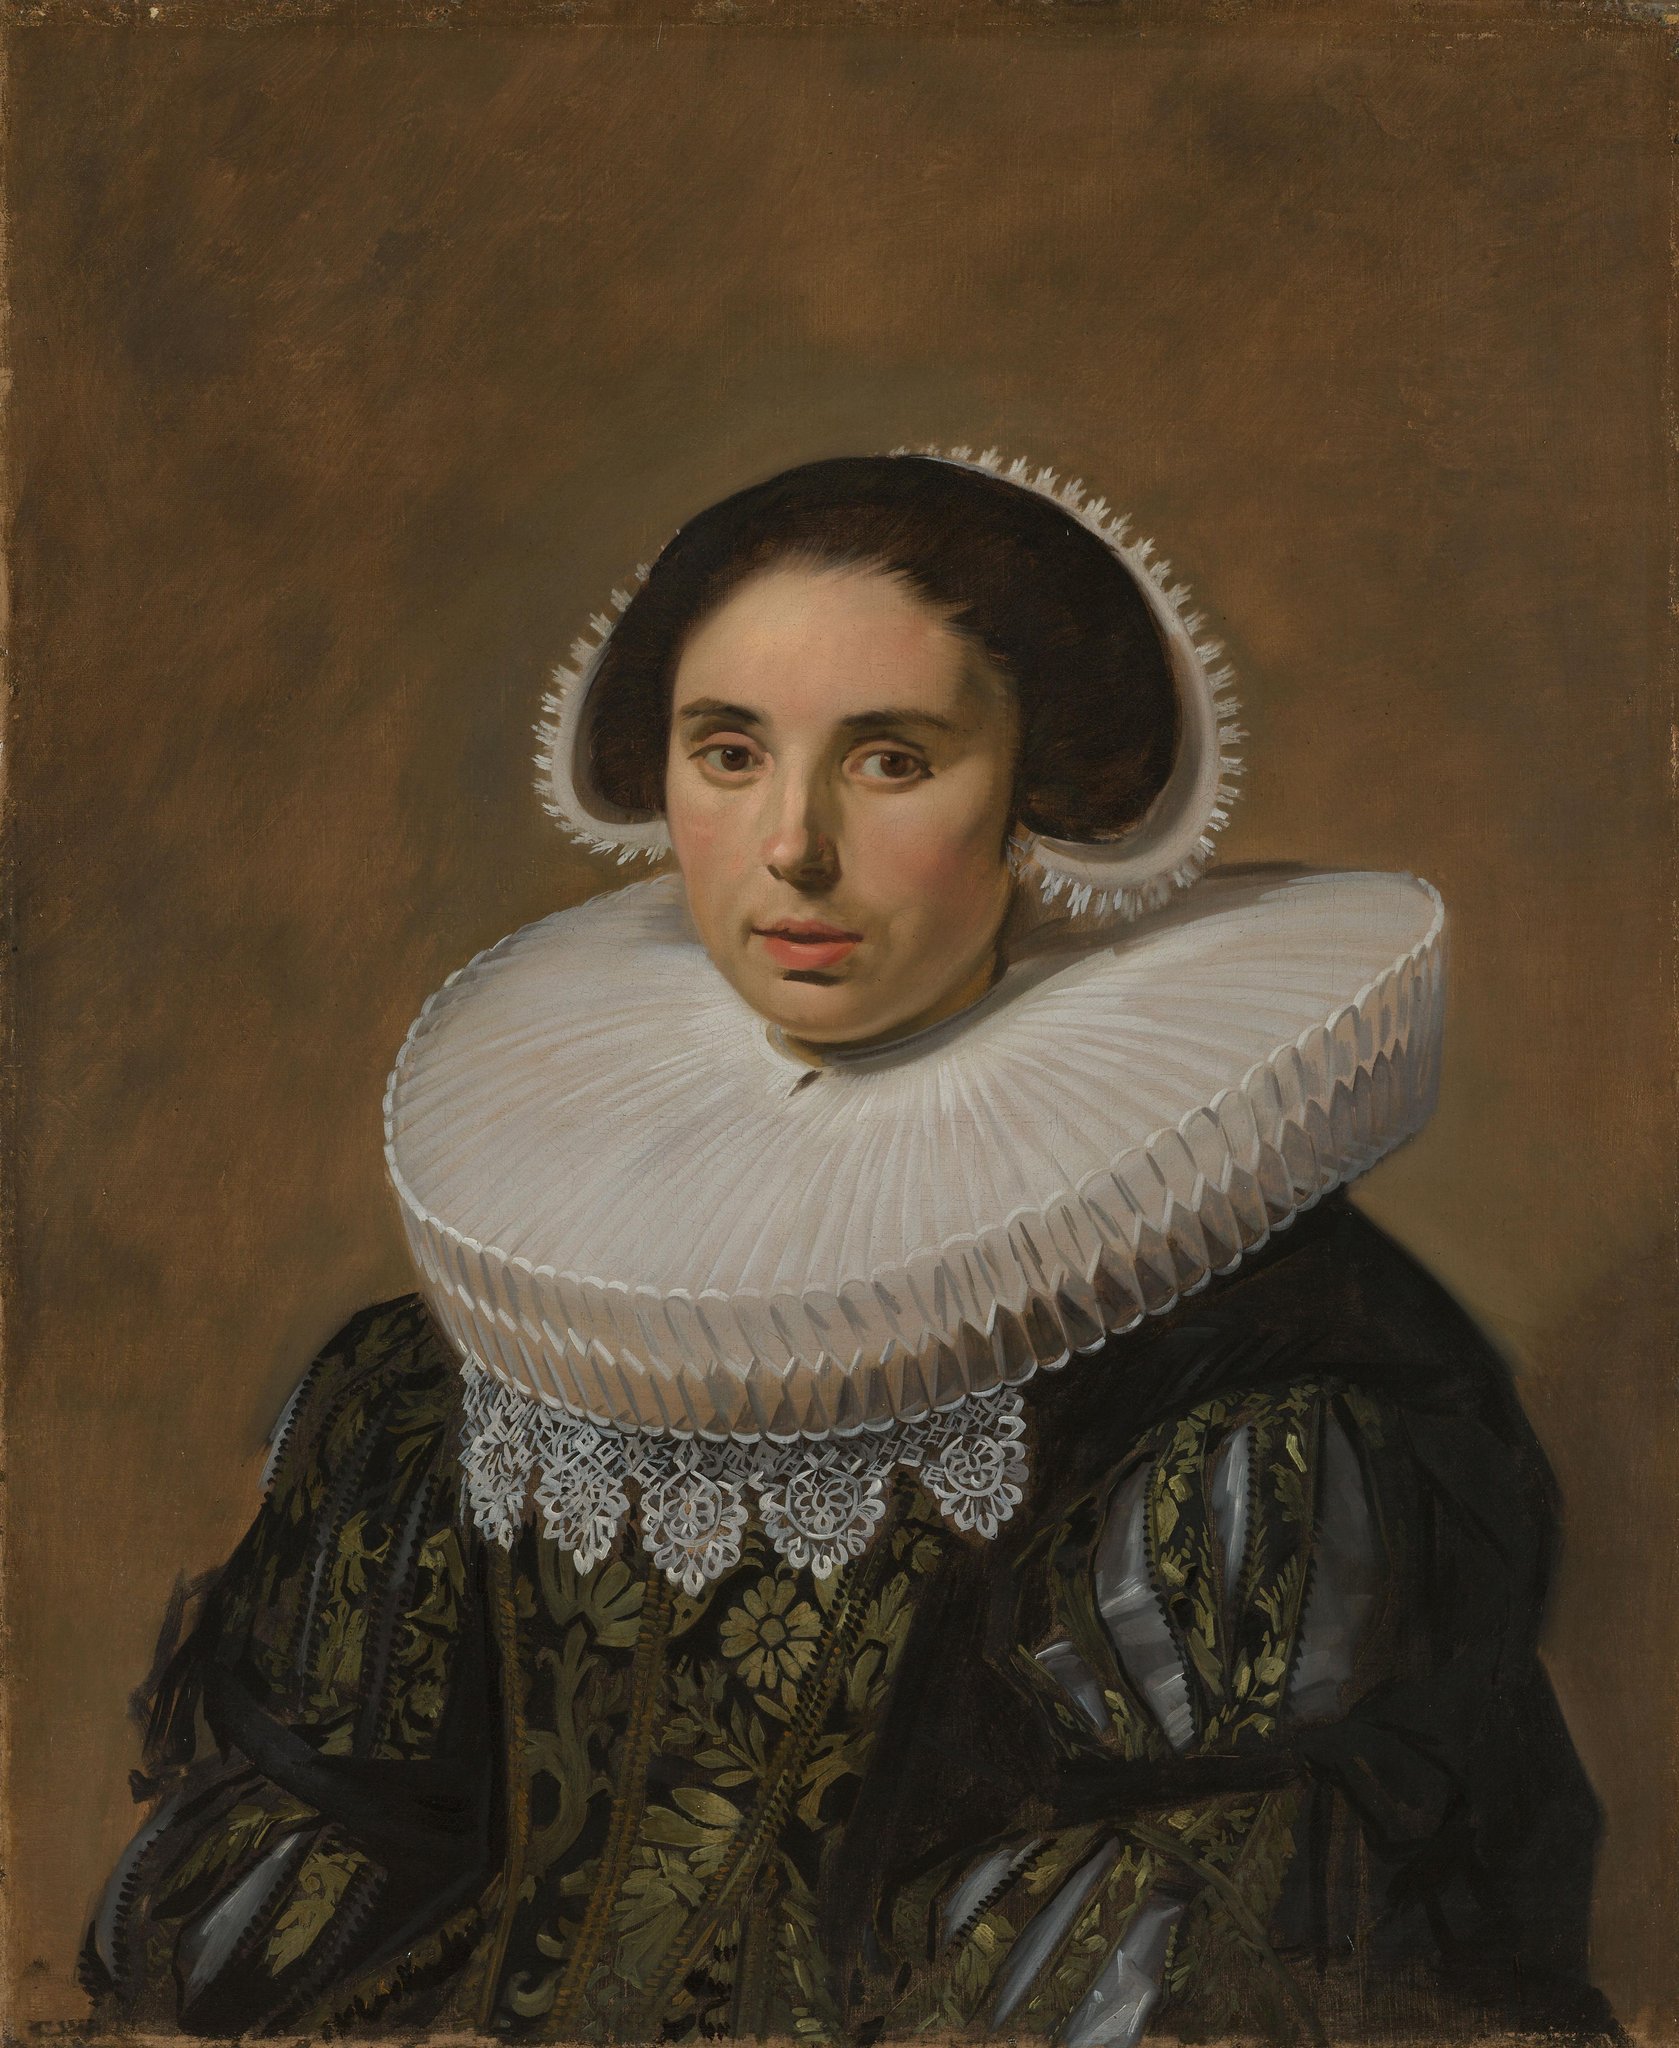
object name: painting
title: Portrait of a Woman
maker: frans hals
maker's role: draughtsman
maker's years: 1582-1666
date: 1637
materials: canvas, oil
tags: historical persons - bb - woman, neck-gear ~ clothing (with name)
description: Jan van de Poll (1597-1678) en Duifje van Gerwen (1618-1658) trouwden in 1637. Duifje was de jongste dochter van een rijke Amsterdamse wijnhandelaar aan de Warmoesstraat. Jan werd zeven keer burgemeester van Amsterdam en klom in 1650 op tot de hoogste rang van de Amsterdamse schutterij, die van kolonel. In die hoedanigheid werd hij in dat jaar en in het jaar 1653 geportretteerd door respectievelijk Johann Spilberg en Bartholomeus van der Helst, beiden in de collectie van het Amsterdam Museum. Zijn gezicht op de deze werken is goed te vergelijken met dat in het portret van Frans Hals, dat kort na het huwelijk met Duifje zal zijn vervaardigd. Het zijn de enige huwelijkspendanten van een Amsterdams stel dat Frans Hals heeft vervaardigd. Jan en Duifje reisden er rond 1637 speciaal voor naar Haarlem. De aanbeveling om de Haarlemmer Frans Hals de huwelijkspendanten (bij elkaar behorende werken) te laten schilderen zal van Duifjes oom Willem Warmond zijn gekomen. Warmond figureert zelf als kapitein in het Haarlems schuttersstuk van Hals van tien jaar eerder. In 1633 begon Hals aan zijn enige groepsportret met Amsterdamse schutters, de ‘Magere compagnie’. Enkele schutters waren niet bereid om naar Haarlem af te reizen om door Hals te worden geportretteerd. Vandaar dat het schilderij 1637 is afgemaakt door de Amsterdamse schilder Pieter Codde. Jan en Duifje hebben kennelijk van dat gat in Hals’ agenda geprofiteerd. Zij waren wel bereid om naar Haarlem te gaan. De portretten van Jan van de Poll en Duifje van Gerwen zijn de enige pendanten van een Amsterdams stel dat Frans Hals heeft vervaardigd. Toen de twee portretten in 1885 het Rijksmuseum binnenkwamen als onderdeel van een legaat, koppelde directeur Frederik Obreen de namen Nicolaes Hasselaer (1593-1635) en Sara Wolphaerts van Diemen (1594-1667) aan de portretten. Rijksmuseumconservator 17de-eeuwse Nederlandse schilderkunst Jonathan Bikker heeft onlangs kunnen vaststellen dat de eerdere identificatie van de geportretteerden niet klopte. Testamenten van de klein- en achterkleinkinderen van Hasselaer en Van Diemen tonen aan dat de portretten onmogelijk in de verervingslijn passen. Jonathan heeft het portret van Jan van de Poll vergeleken met bovengenoemde later geschilderde portretten. Van Duifje van Gerwen zijn geen andere portretten bekend. Jan en Duifje zijn directe voorouders van Jonkheer Jan Stanislaus Robert van de Poll, die de schilderijen in 1885 aan het Rijksmuseum schonk.